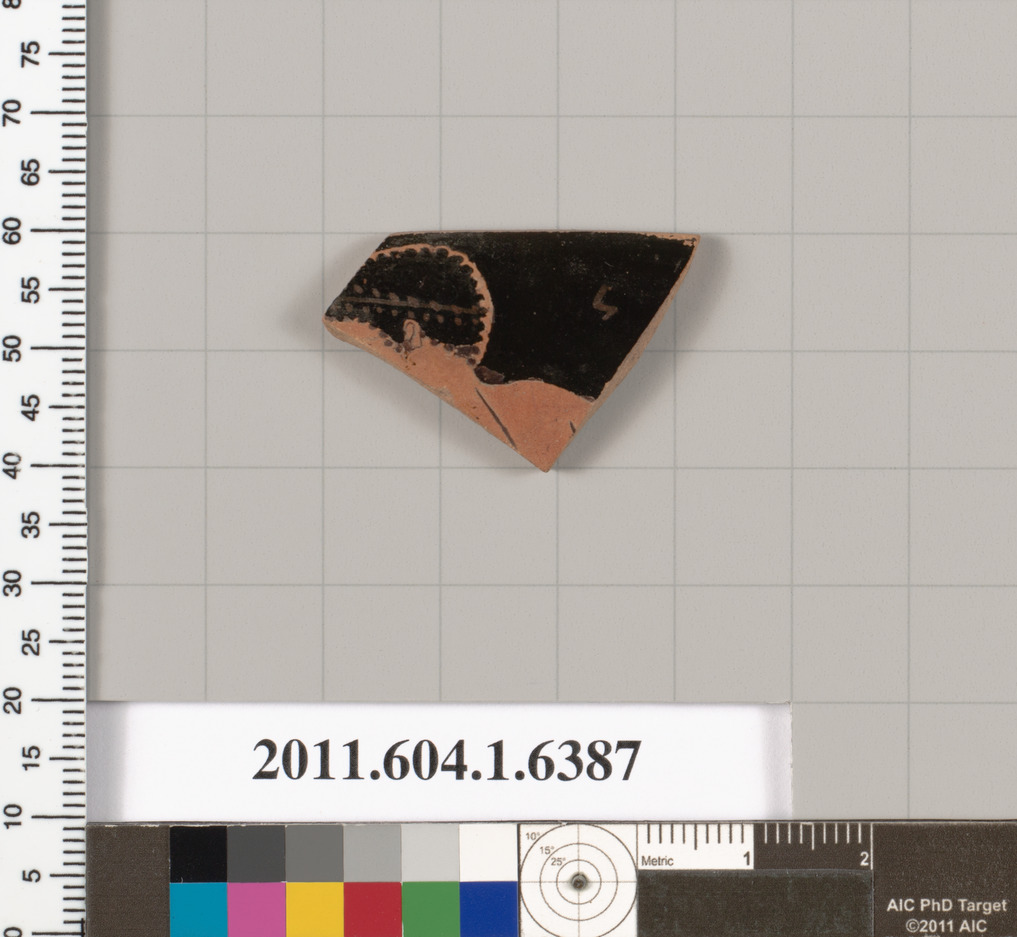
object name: kylix fragment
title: Terracotta rim fragment of a kylix (drinking cup)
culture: greek, attic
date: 490-480 BCE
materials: terracotta